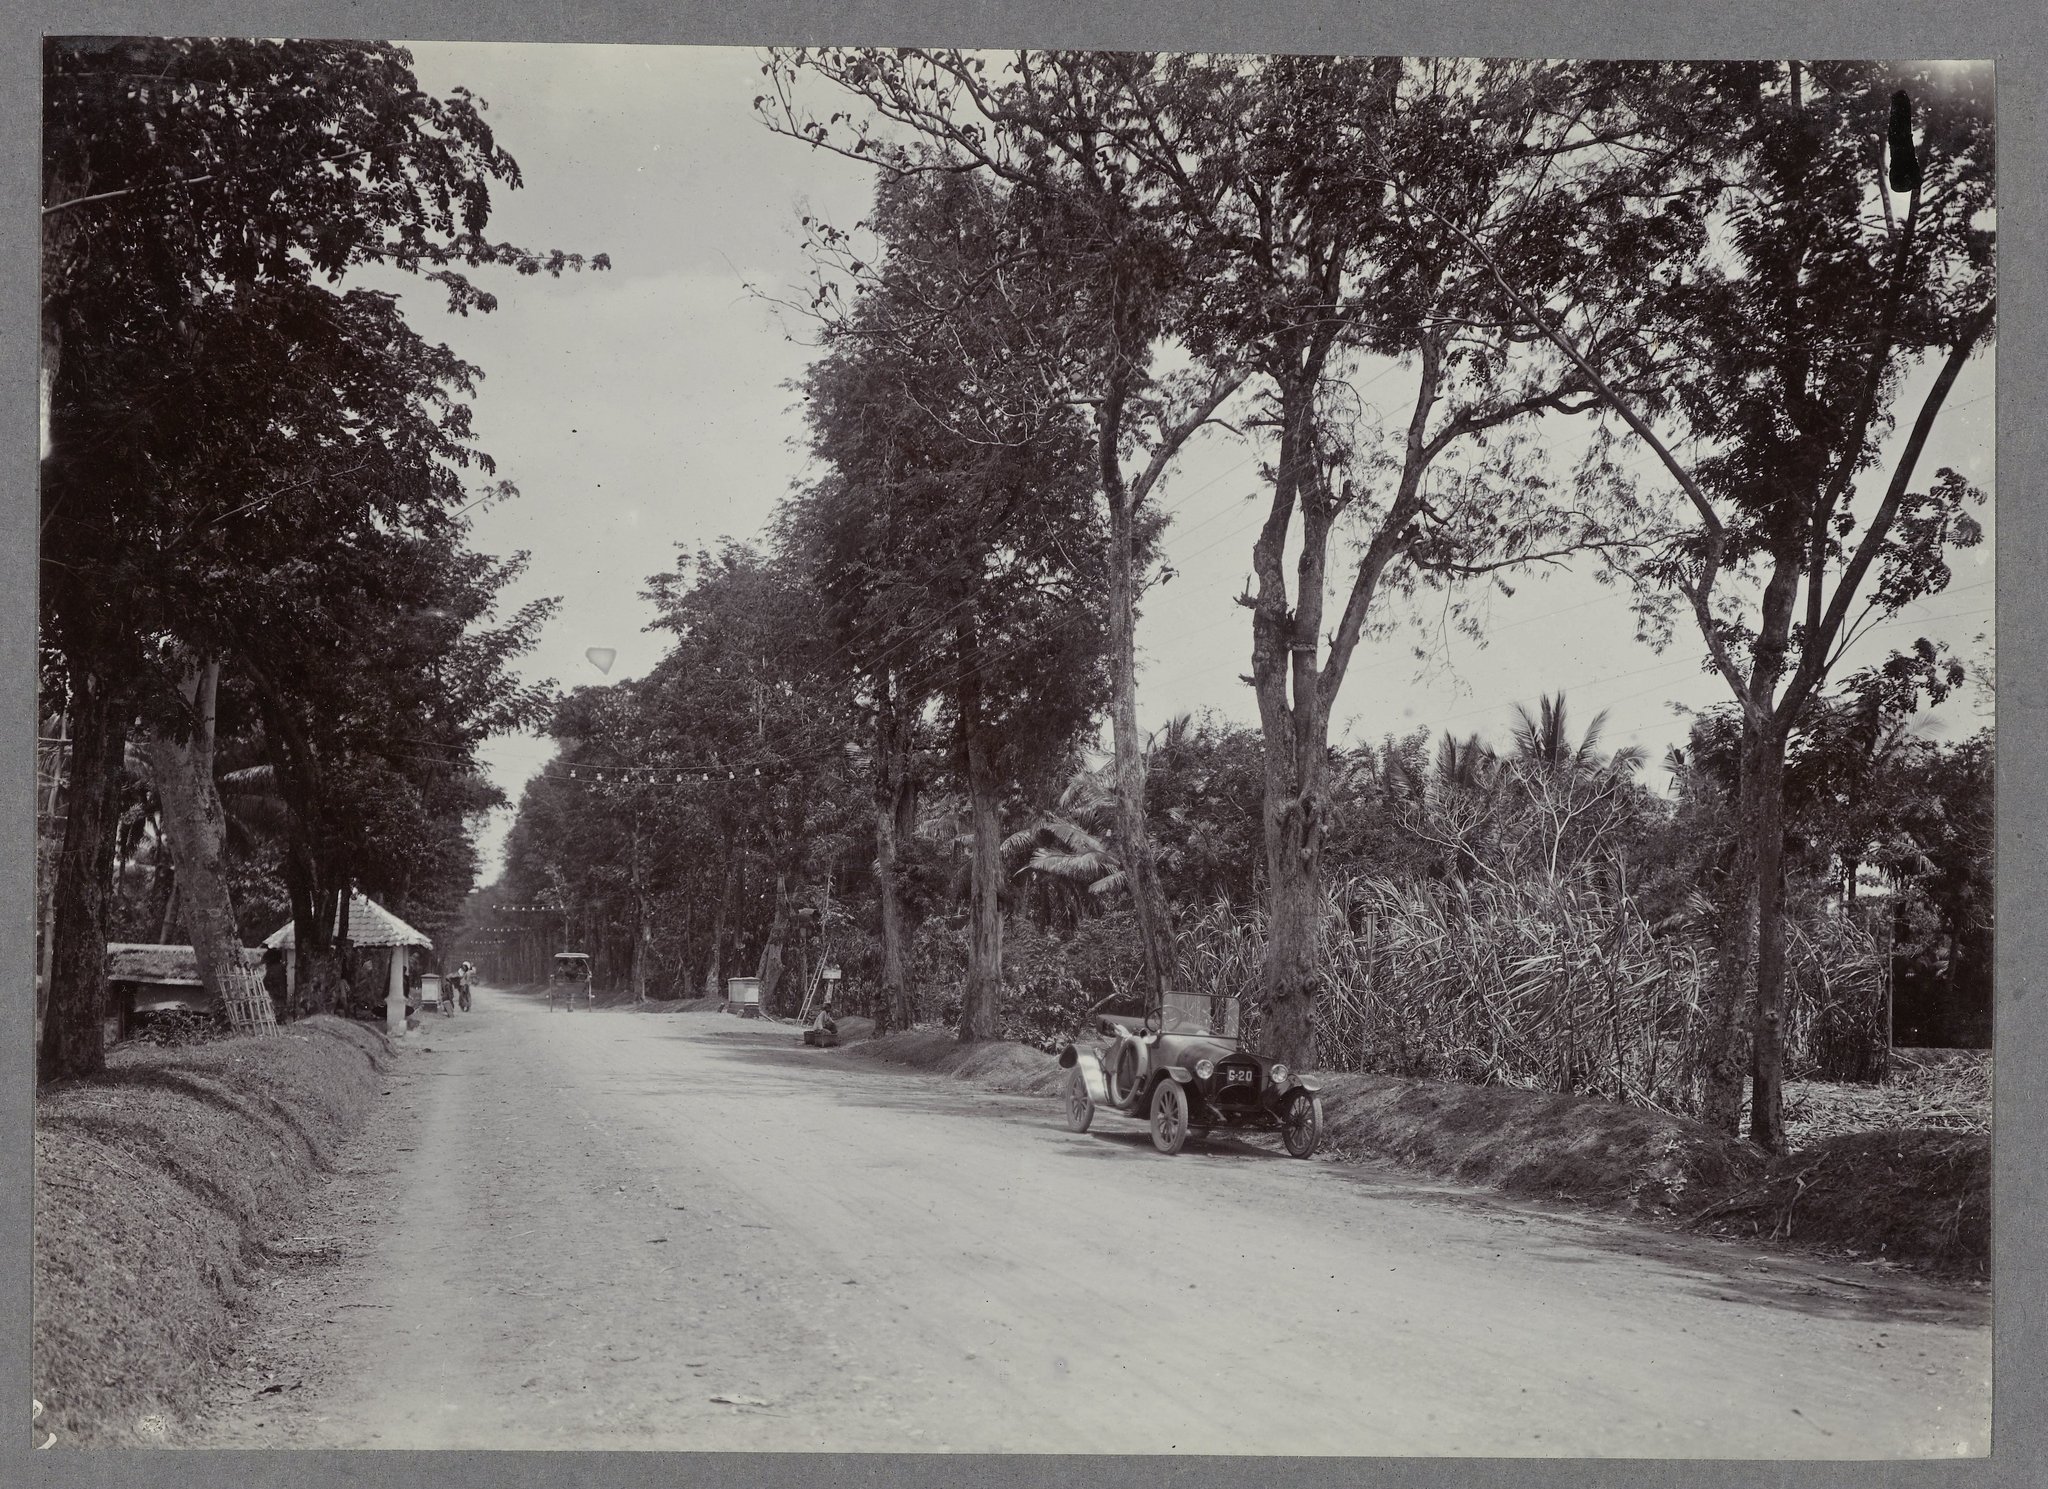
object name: photograph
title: Auto langs een weg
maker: Anonymous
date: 1900-1919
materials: photographic support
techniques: collodion silver print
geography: comal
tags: colonial system, plantation, (non-fruit) products of plants or trees: sugarcane, automobile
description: Een auto geparkeerd langs de kant van de weg. Onderdeel van het fotoalbum van de Tjomal suikerfabriek in de periode ca. 1900-1919.